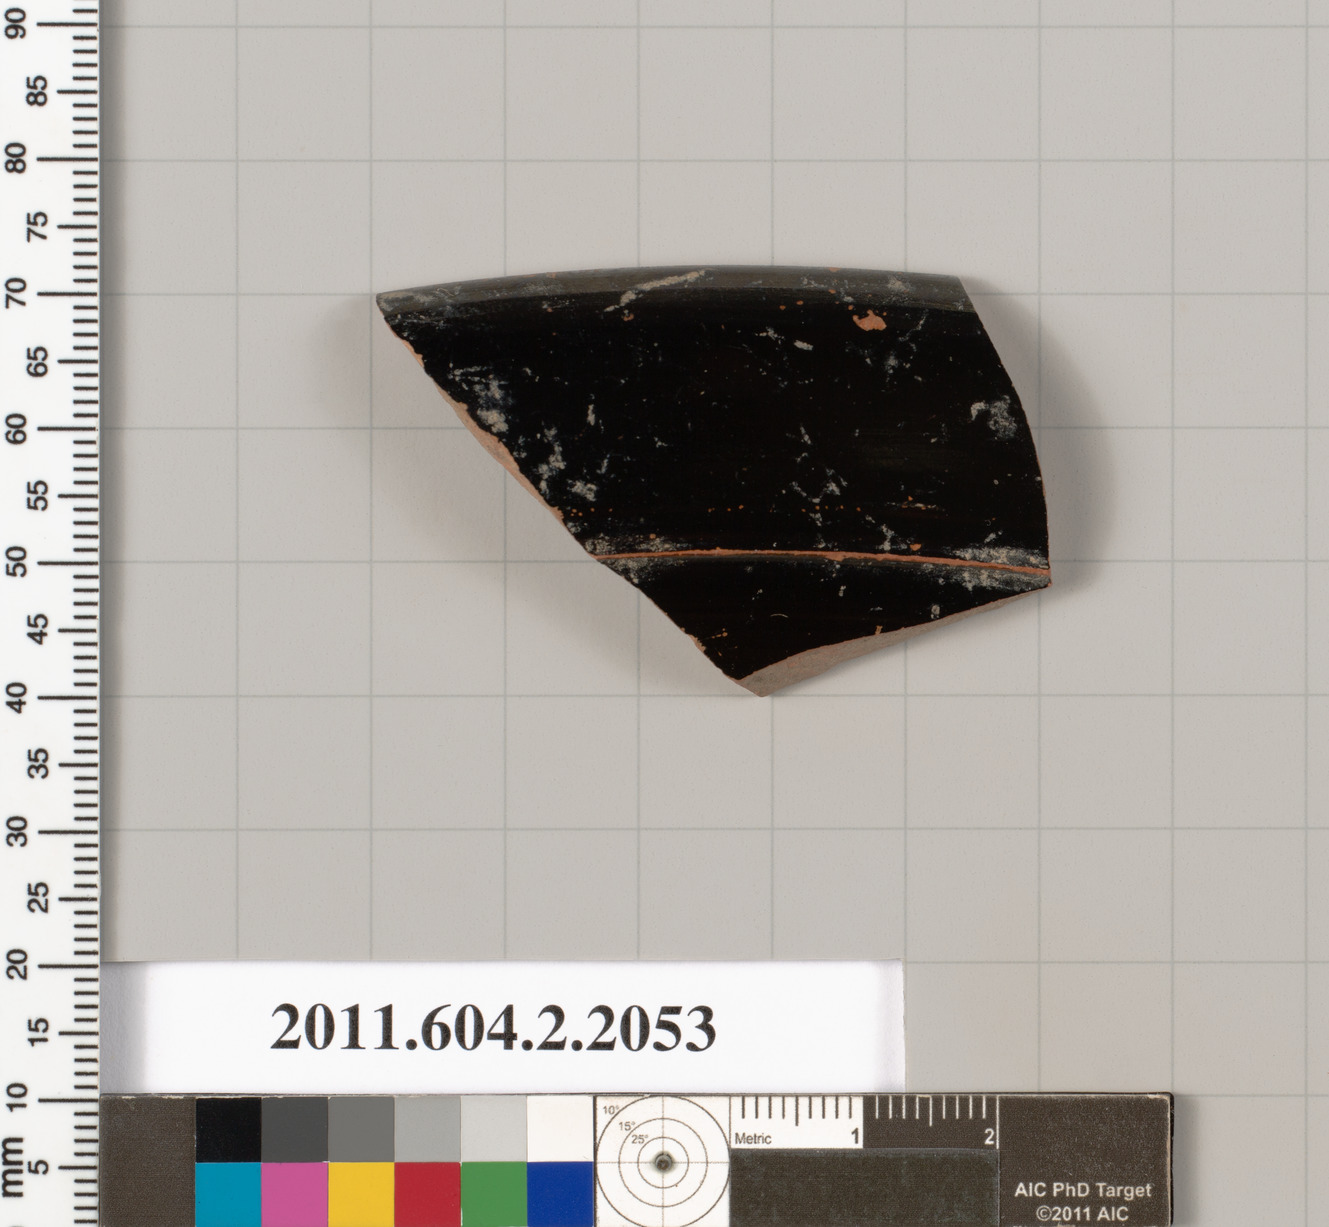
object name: lid fragment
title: Terracotta fragment of a lid?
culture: greek, attic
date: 500 BCE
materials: terracotta